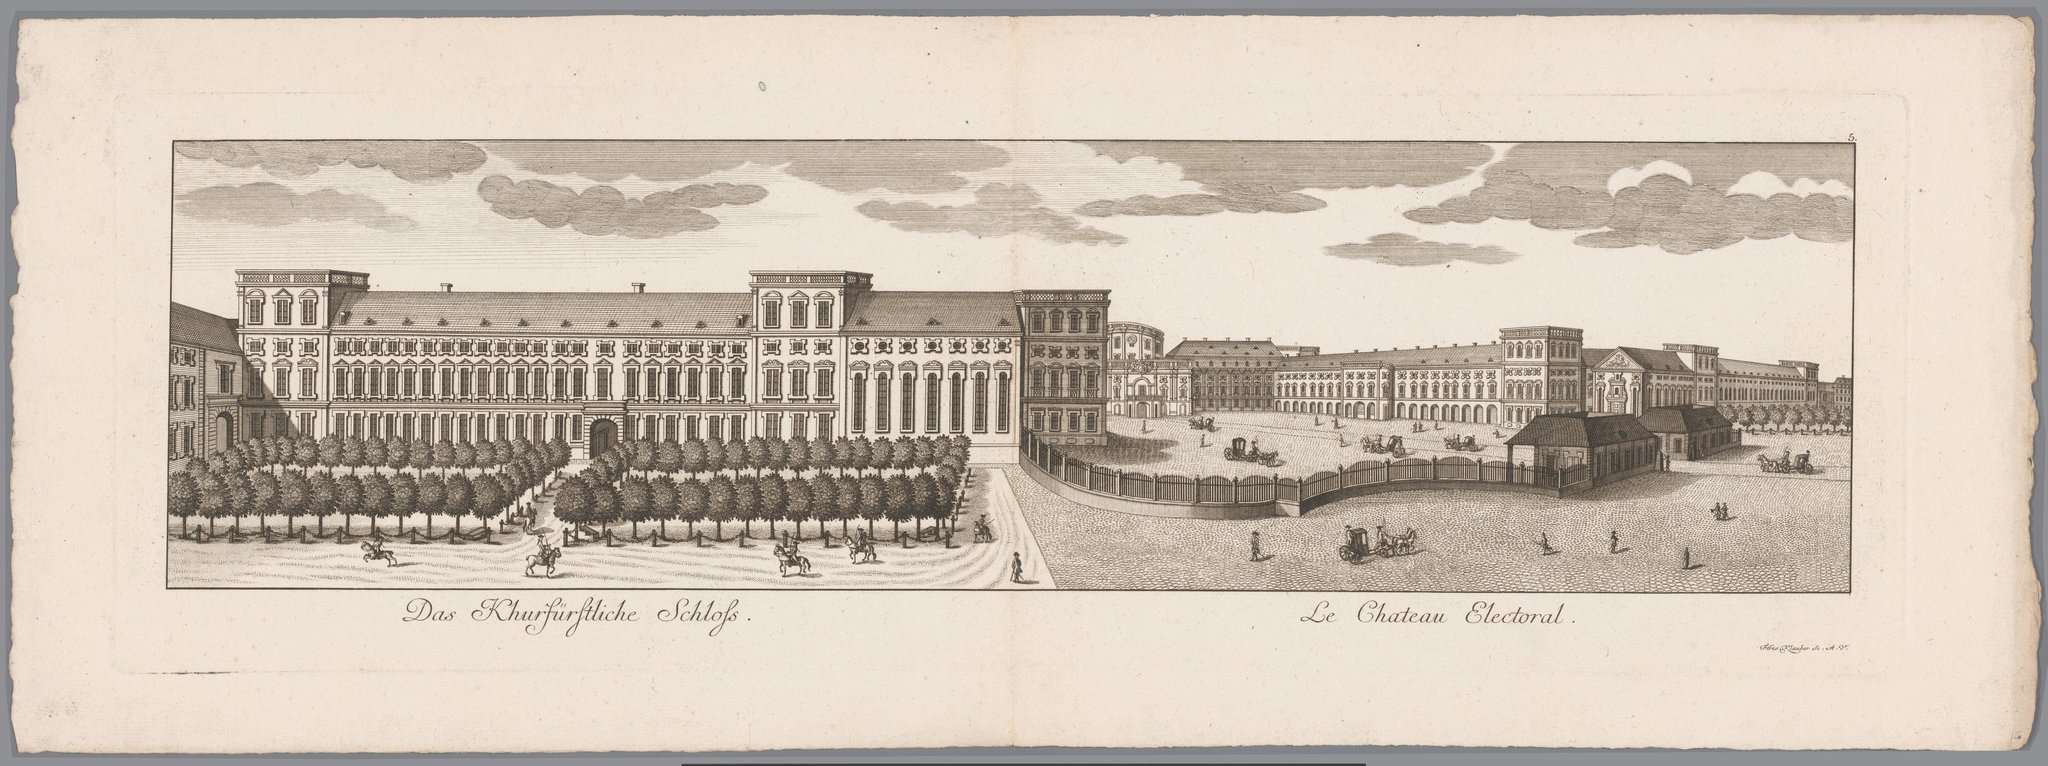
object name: print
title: Vues de Mannheim représentées sur vingt six planches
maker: christian friedrich schwan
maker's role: bookseller, publisher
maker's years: 1733-1815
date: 1782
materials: paper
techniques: engraving, etching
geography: mannheim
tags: palace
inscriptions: collector's mark: Lugt 2228